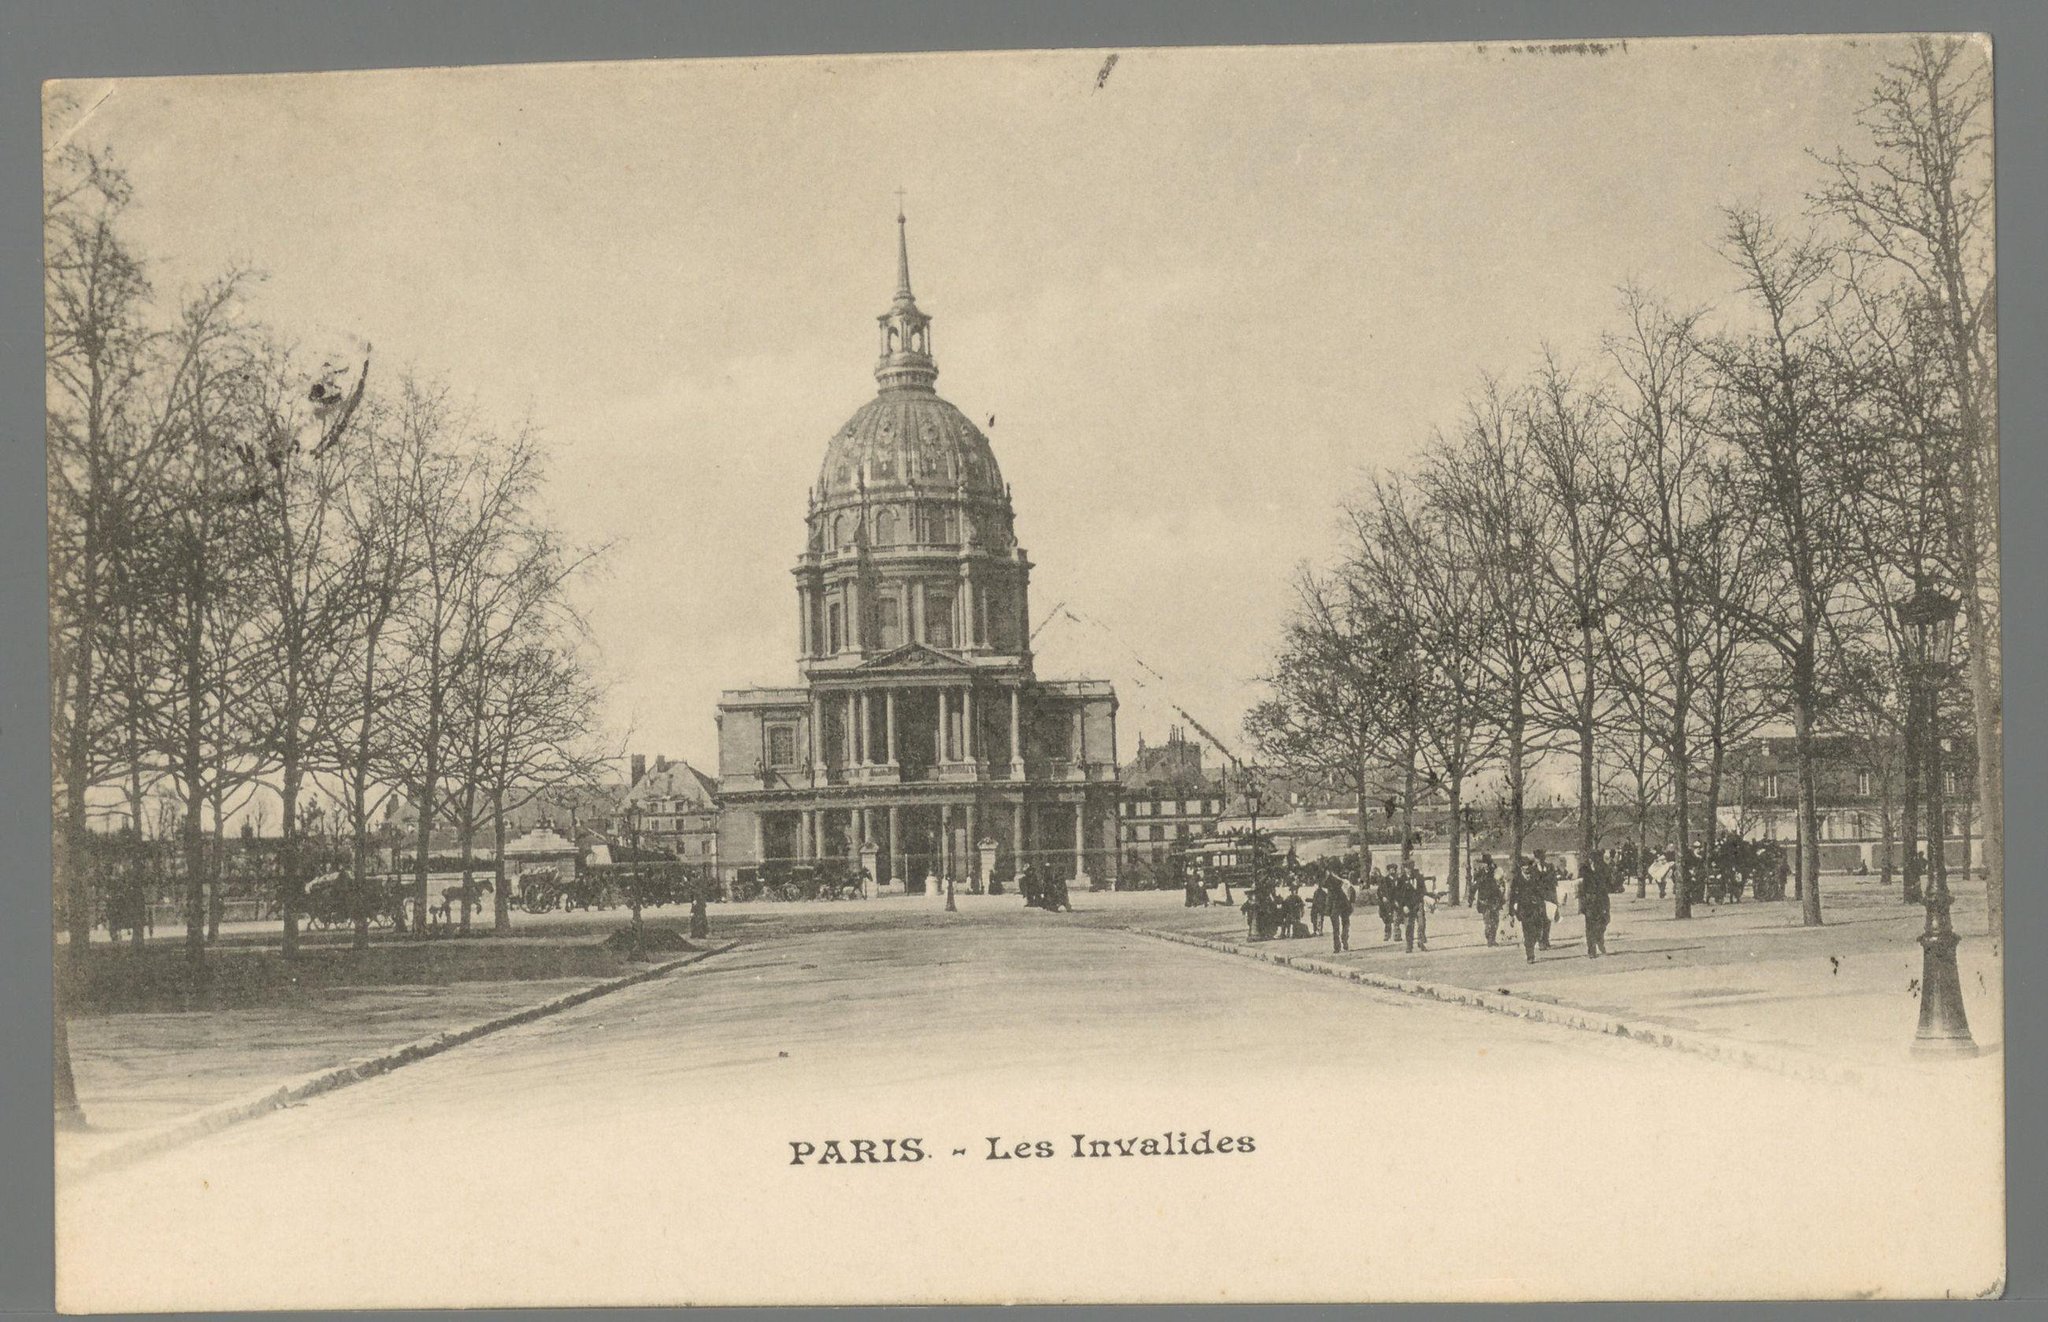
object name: ansichtkaart, prentbriefkaart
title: Paris. Les Invalides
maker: Anonymous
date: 1892-1902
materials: cardboard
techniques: photograph, writing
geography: paris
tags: dome ~ architecture, city-view, and landscape with man-made constructions (+ city(-scape) with figures, staffage)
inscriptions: postage stamp